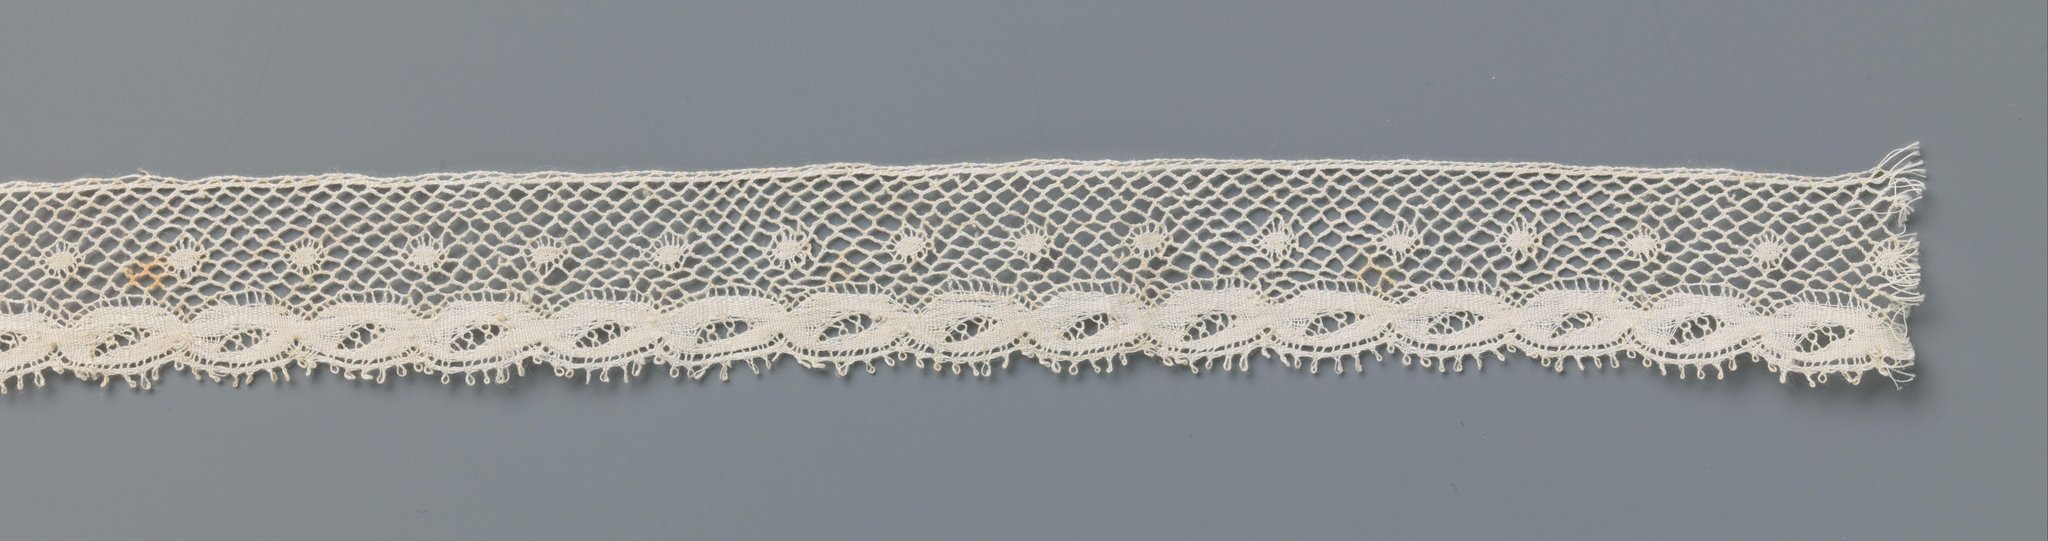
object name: strip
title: Strook kloskant met getorste bandjes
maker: Anonymous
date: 1920-1929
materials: linen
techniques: lace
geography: s gravenmoer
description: Strook naturelkleurige kloskant, Valenciennes-kant. Tegen een met moesjes bezaaide achtergrond lopen twee getorste bandjes langs de geschulpte kant.